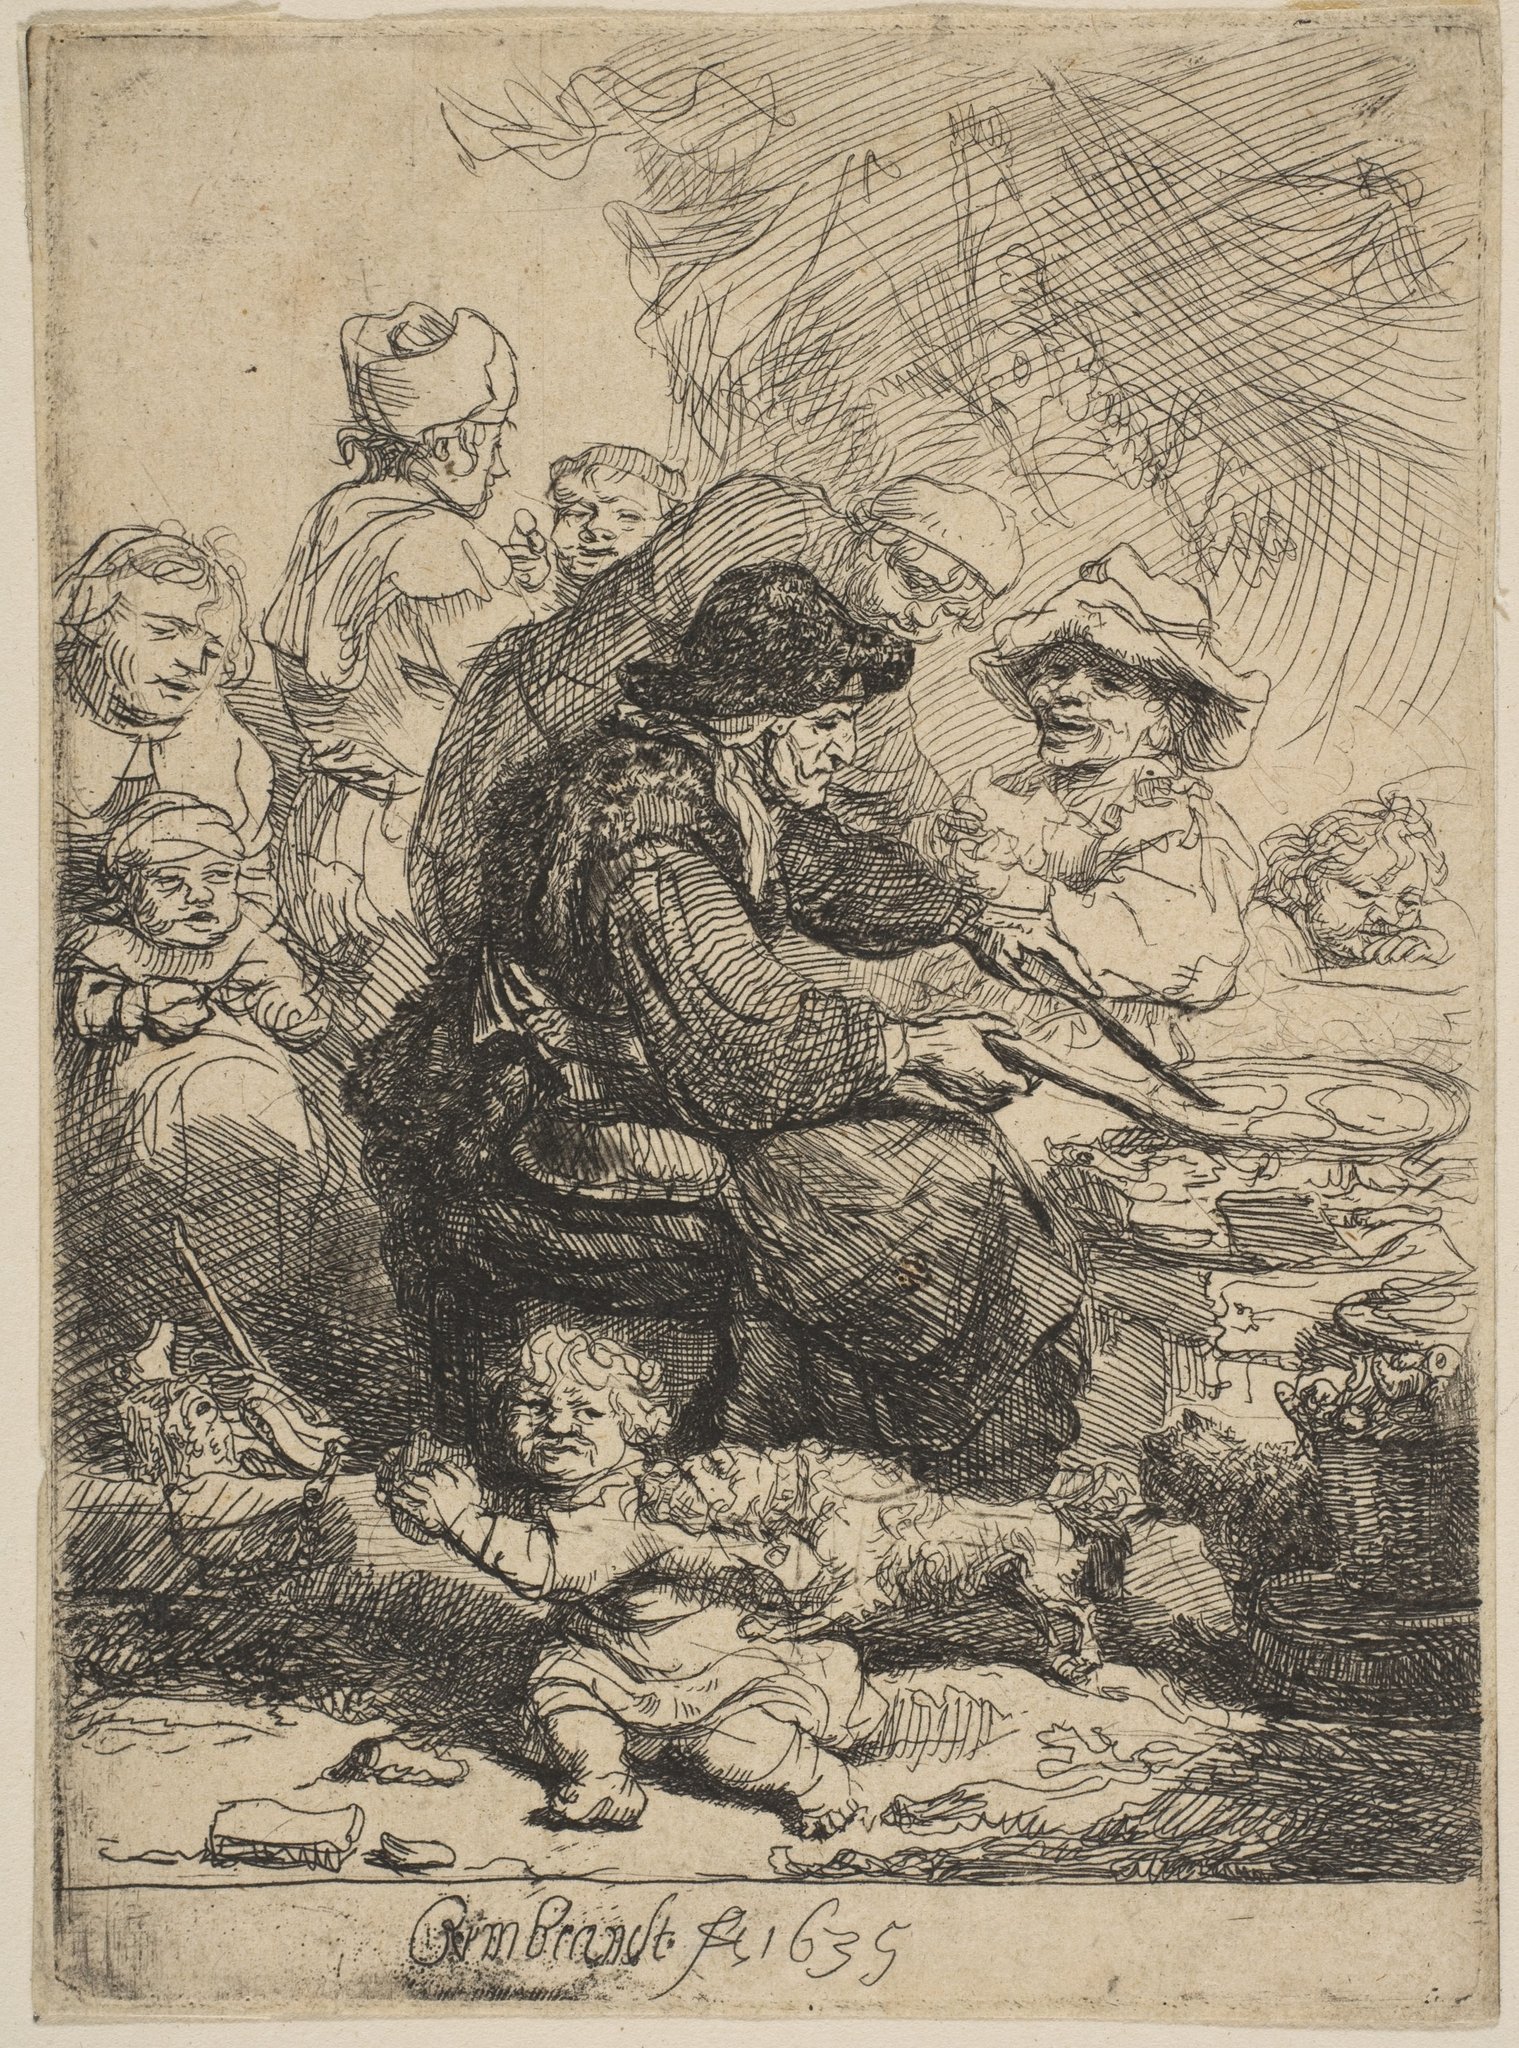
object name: print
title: The Pancake Woman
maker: rembrandt van rijn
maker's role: artist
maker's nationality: dutch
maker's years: 1606-1669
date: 1635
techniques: etching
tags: food,children,women,dogs,cooking